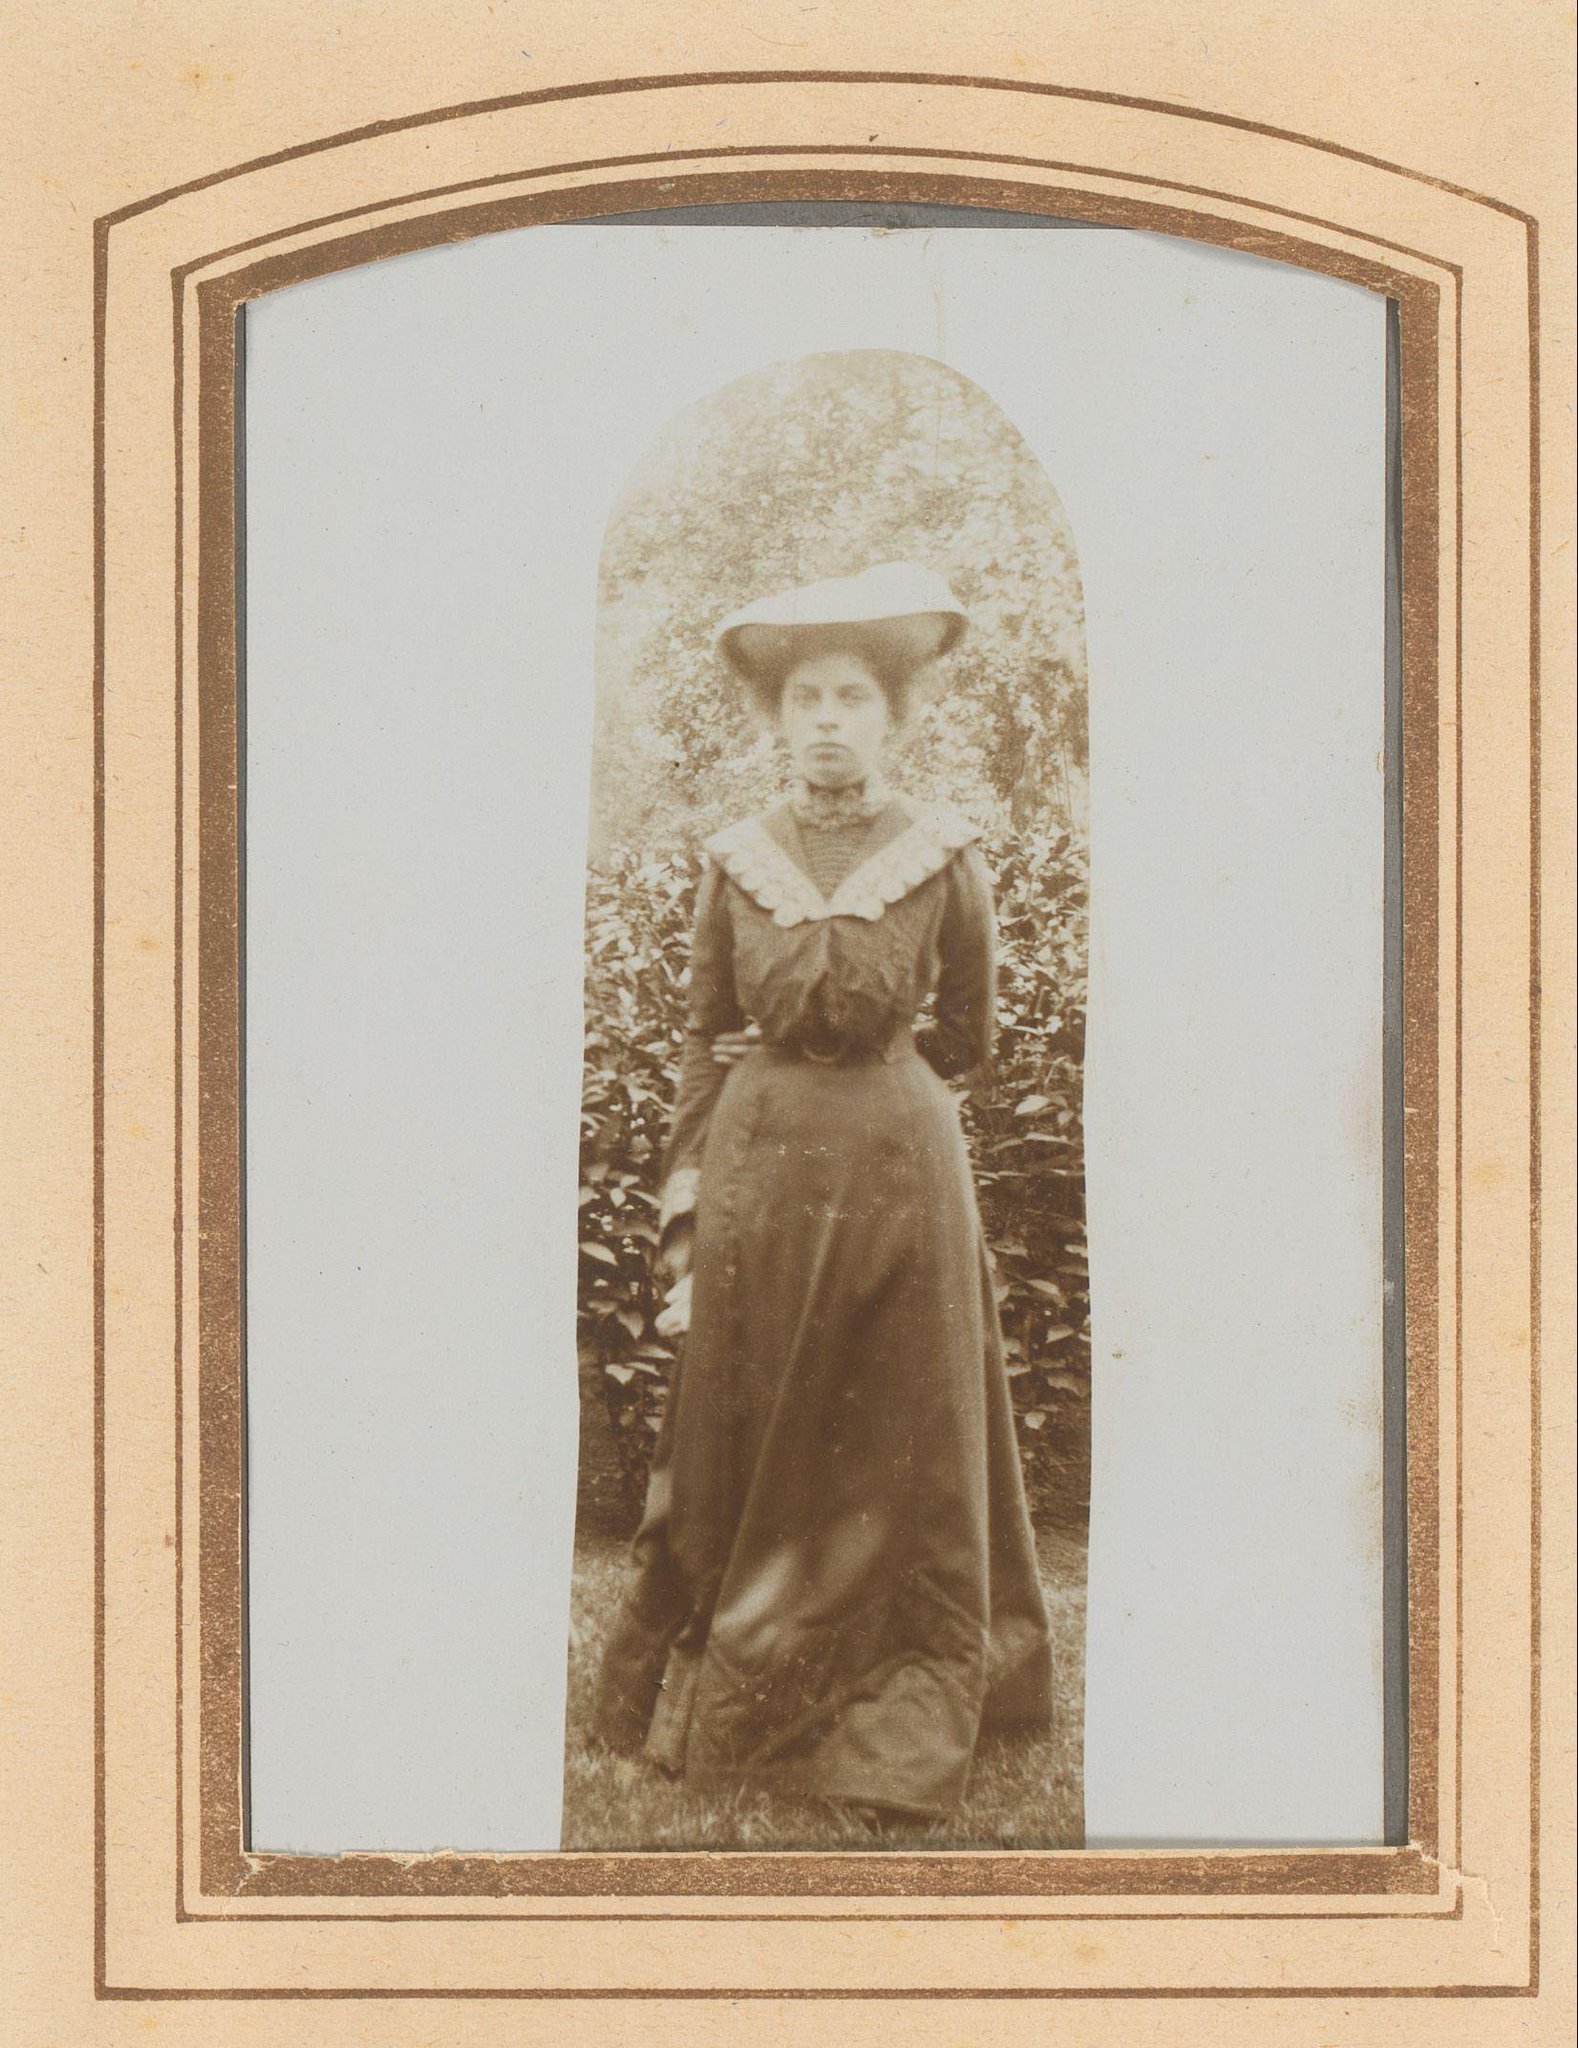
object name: photograph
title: Portret van een staande jonge vrouw met hoed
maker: Anonymous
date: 1880-1920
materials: cardboard, photographic support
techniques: collodion silver print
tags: adolescent, young woman, maiden, head-gear: hat